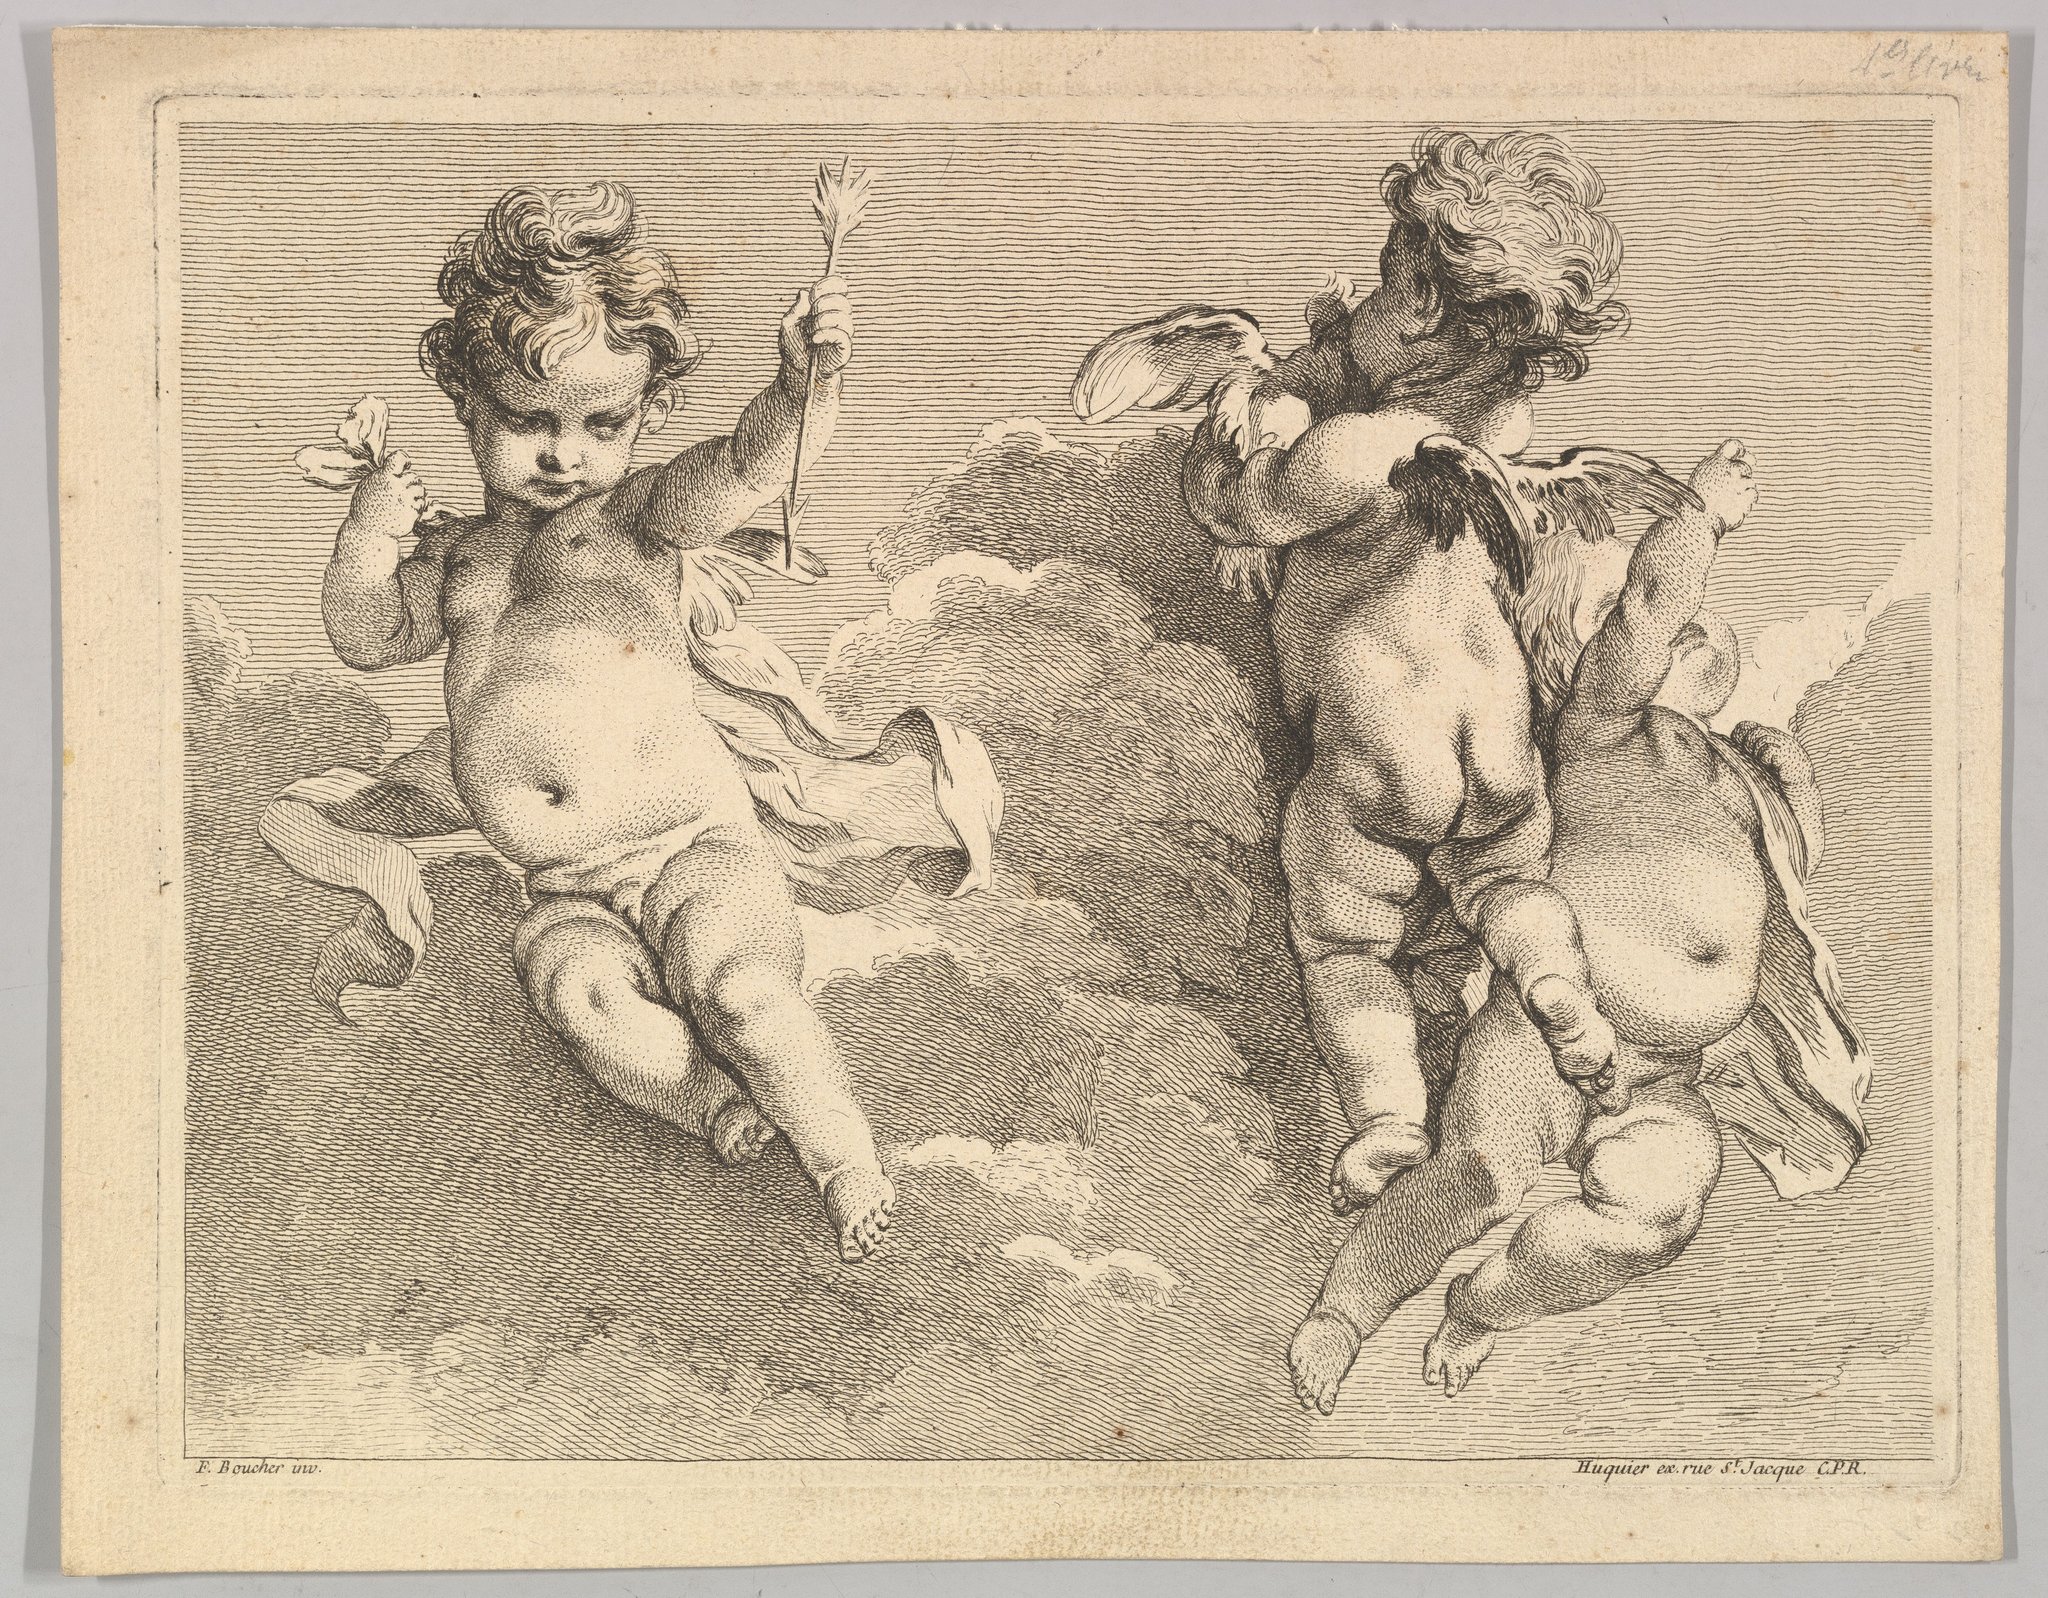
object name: collection ornament architecture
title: Trois Amours dont un tient une flèche (Three Loves, one of which holds an arrow), from Premiere Livre de Groupes d'Enfans (First Book of Groups of Children)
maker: pierre alexandre aveline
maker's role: artist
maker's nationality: french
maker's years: 1702-1760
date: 1702-1760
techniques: engraving, etching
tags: cupid